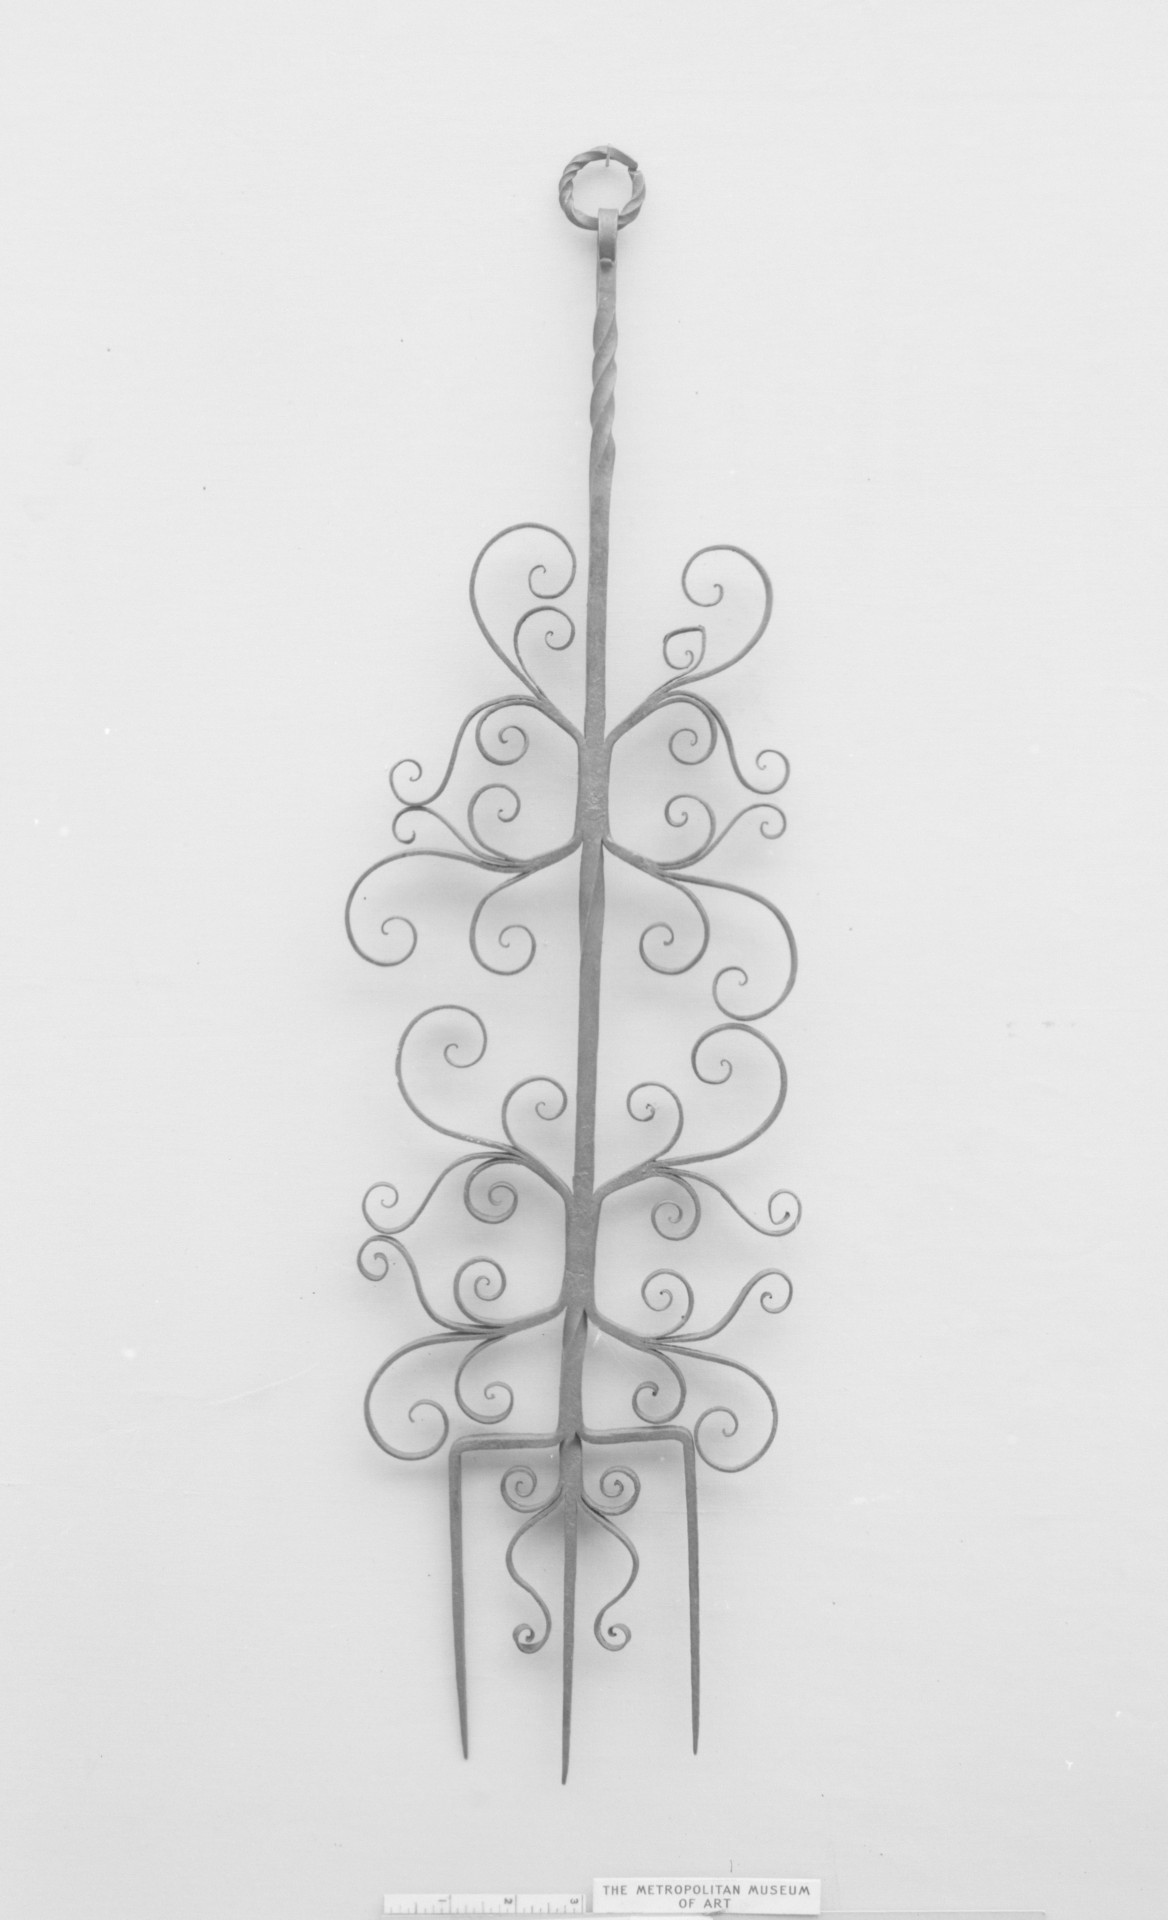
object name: fork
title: Broaching or toasting fork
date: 1601-1700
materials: iron